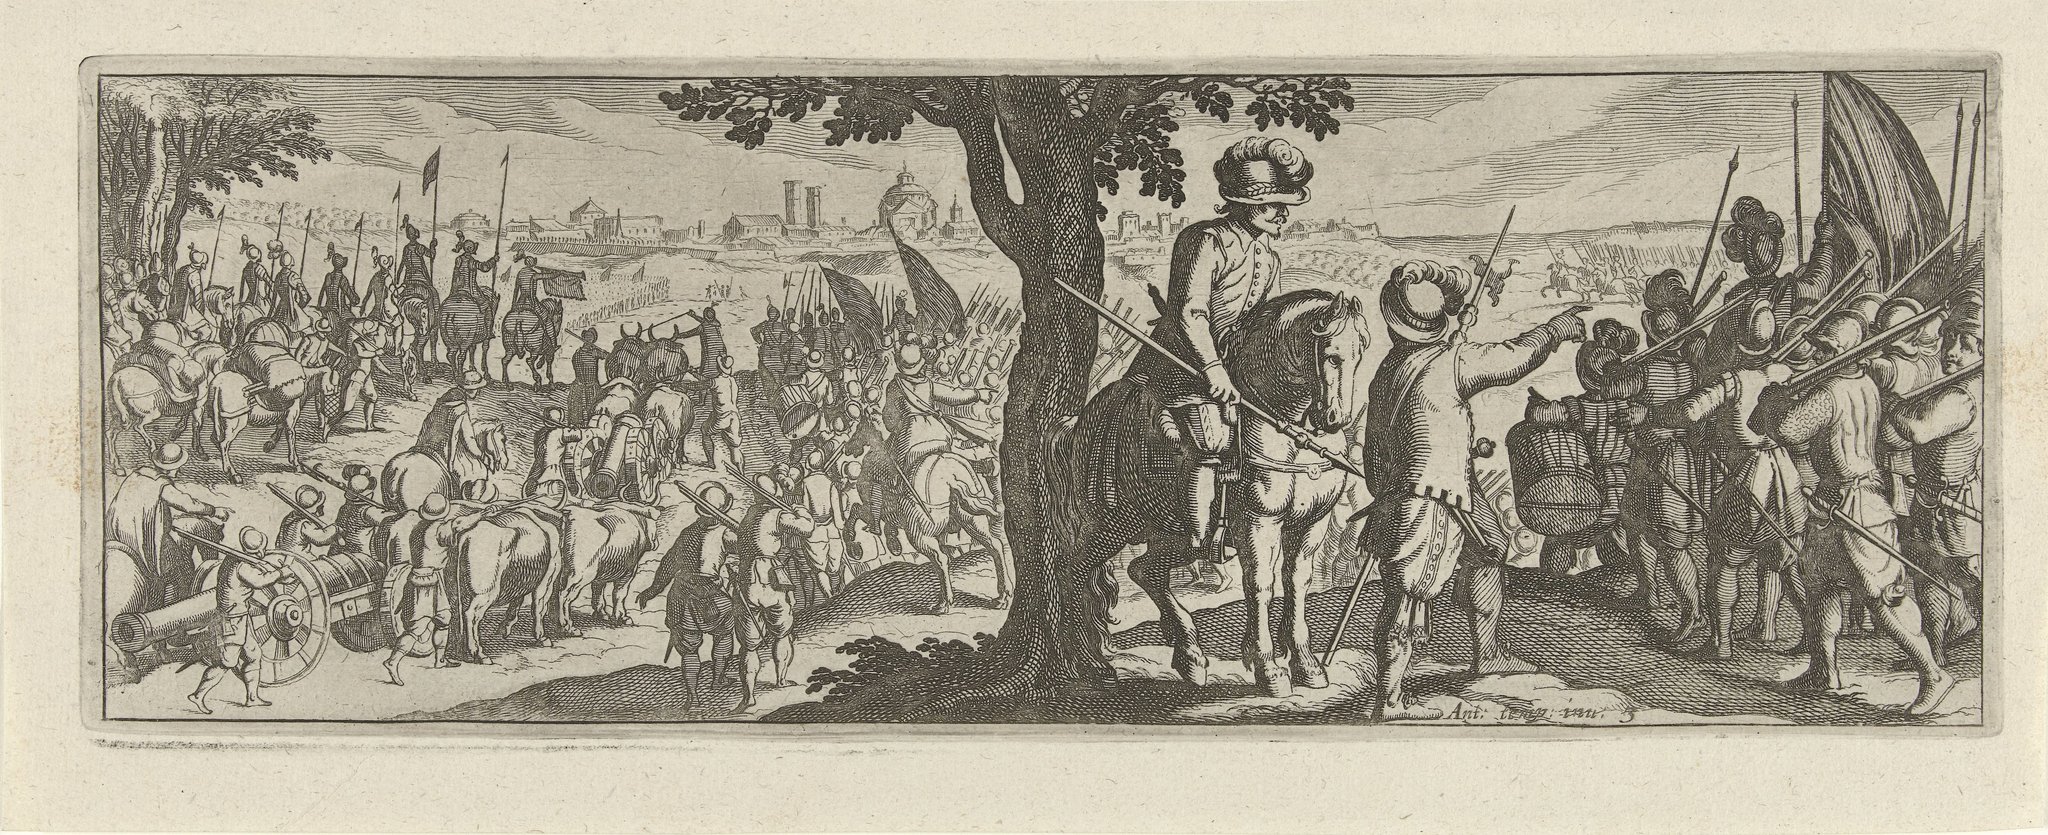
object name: print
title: Cavalerie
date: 1595-1628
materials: paper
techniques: etching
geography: italy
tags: preparation for battle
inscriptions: collector's mark: Lugt 2228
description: Onder een boom praat een cavalerist met een andere soldaten. Rond hen diverse militaire eenheden in een weids landschap.